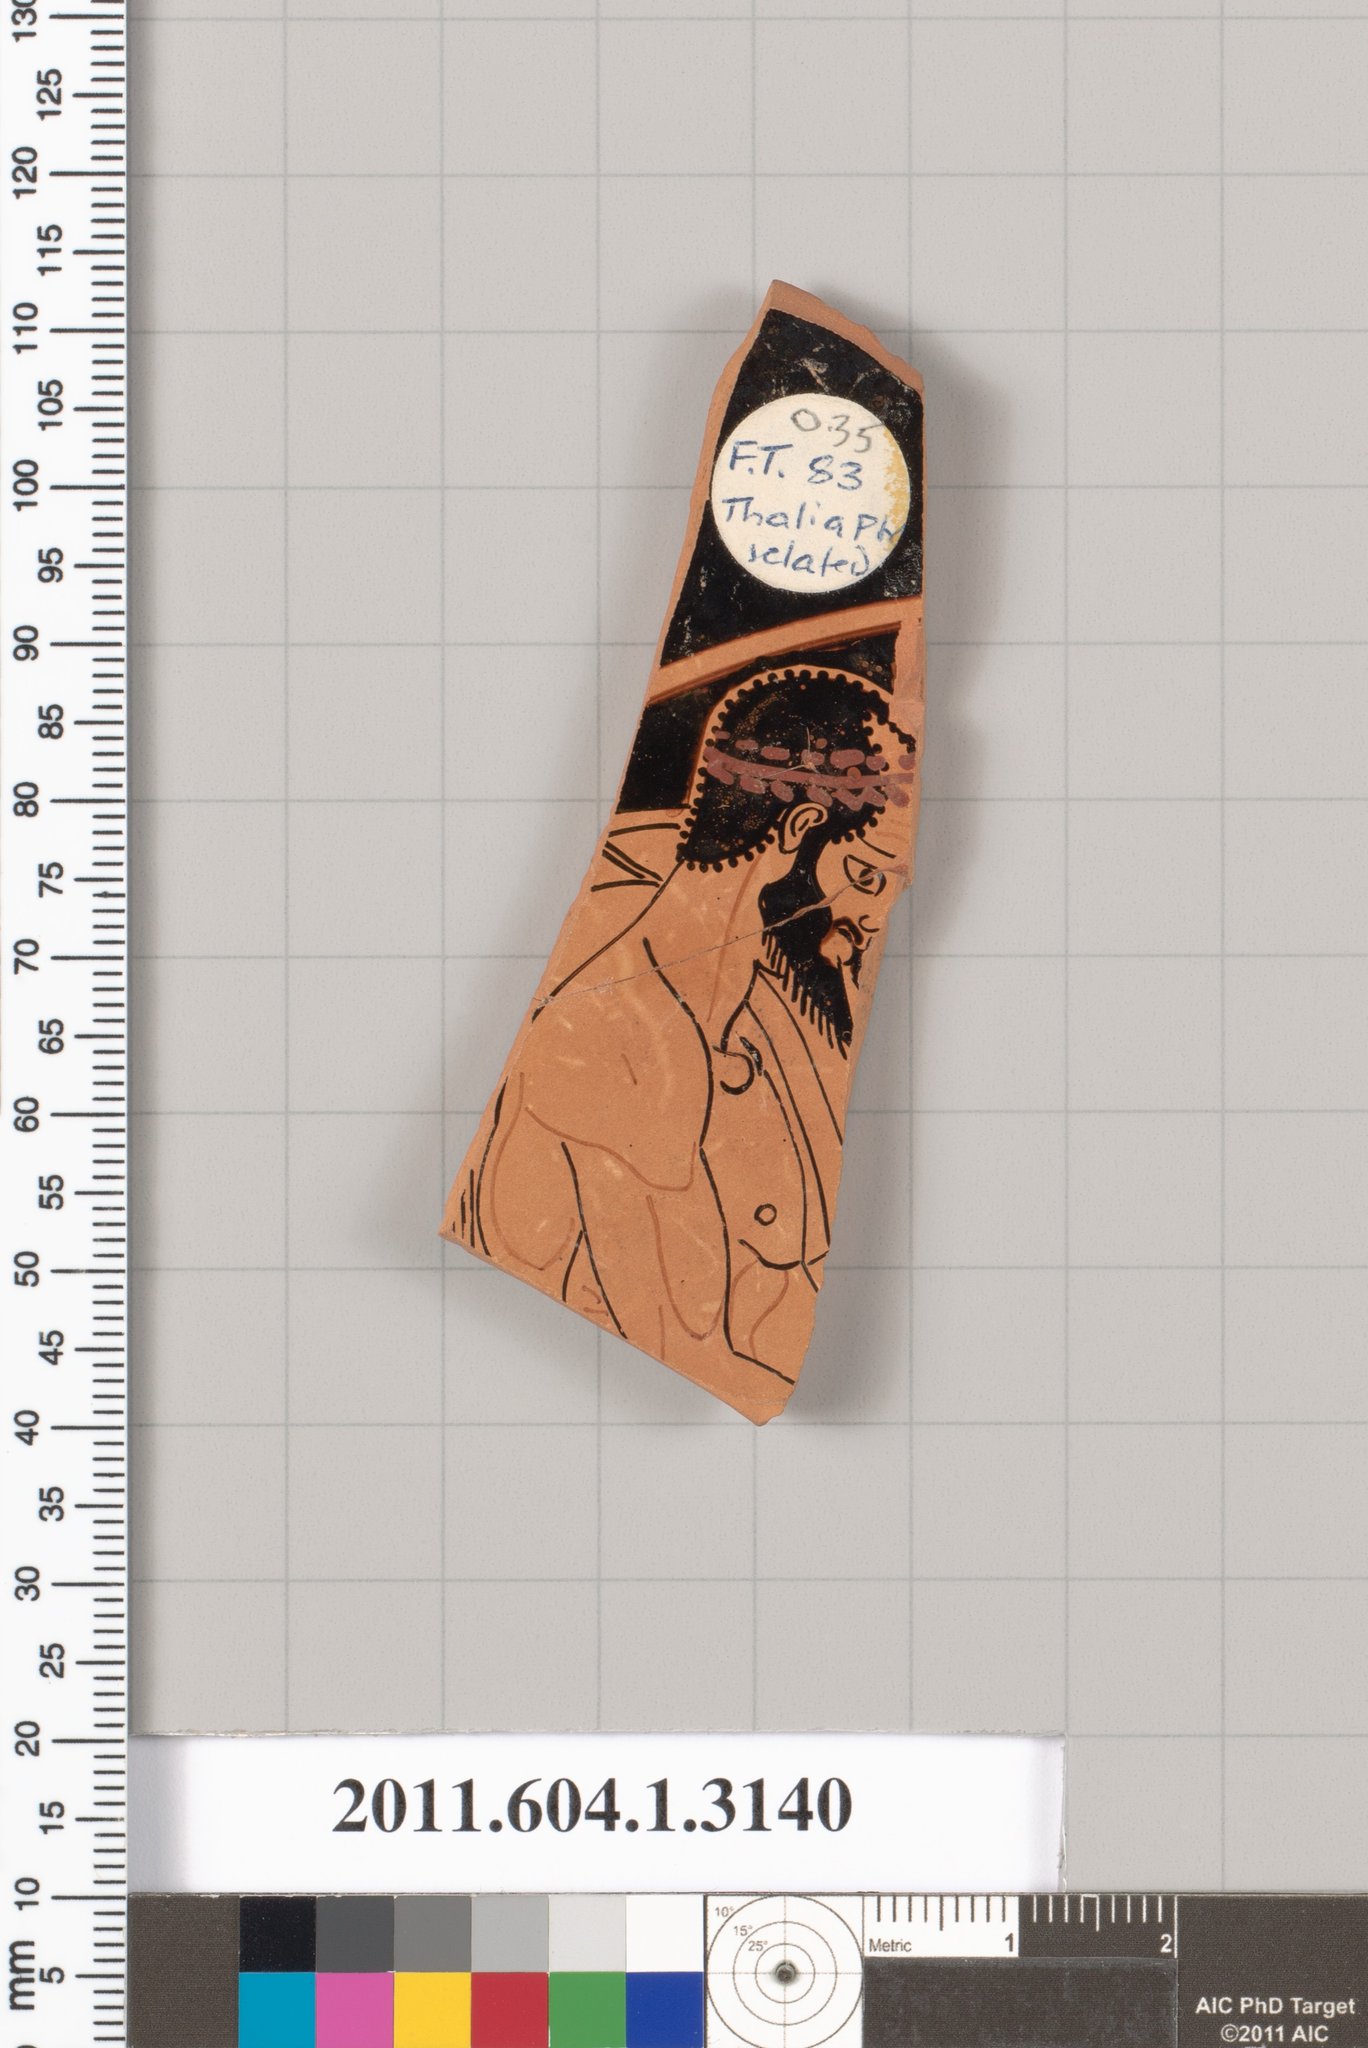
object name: kylix fragment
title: Terracotta fragment of a kylix (drinking cup)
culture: greek, attic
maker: thalia painter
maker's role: artist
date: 510-500 BCE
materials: terracotta